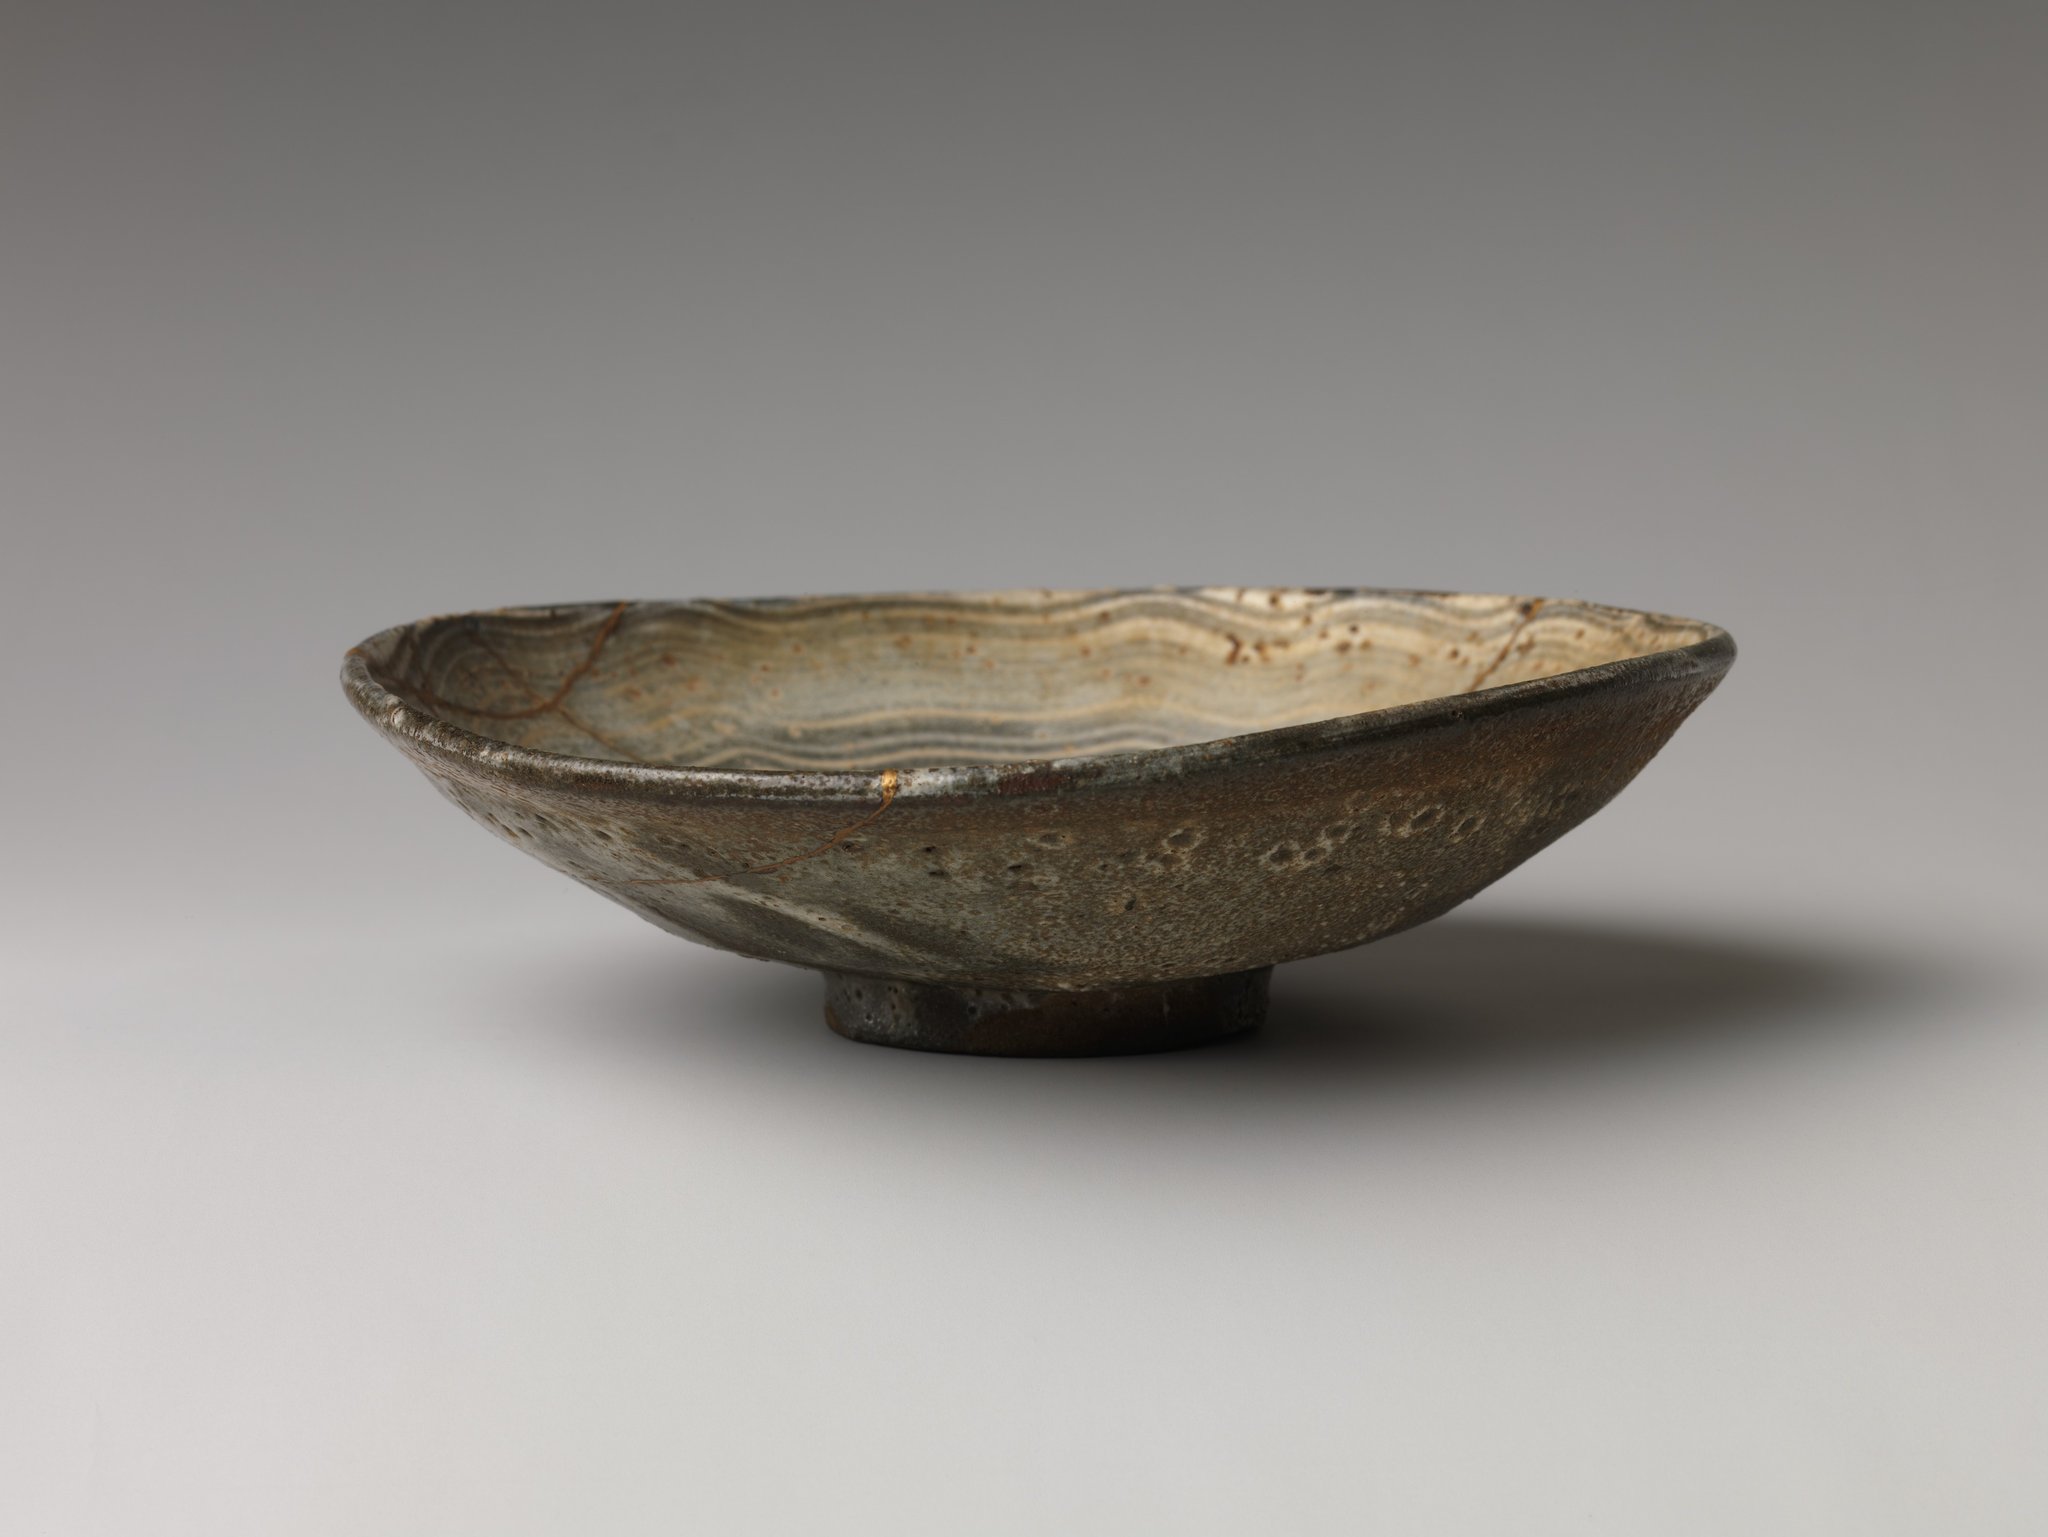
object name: bowl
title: Shallow Bowl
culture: japanese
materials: glaze, pottery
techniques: inlay